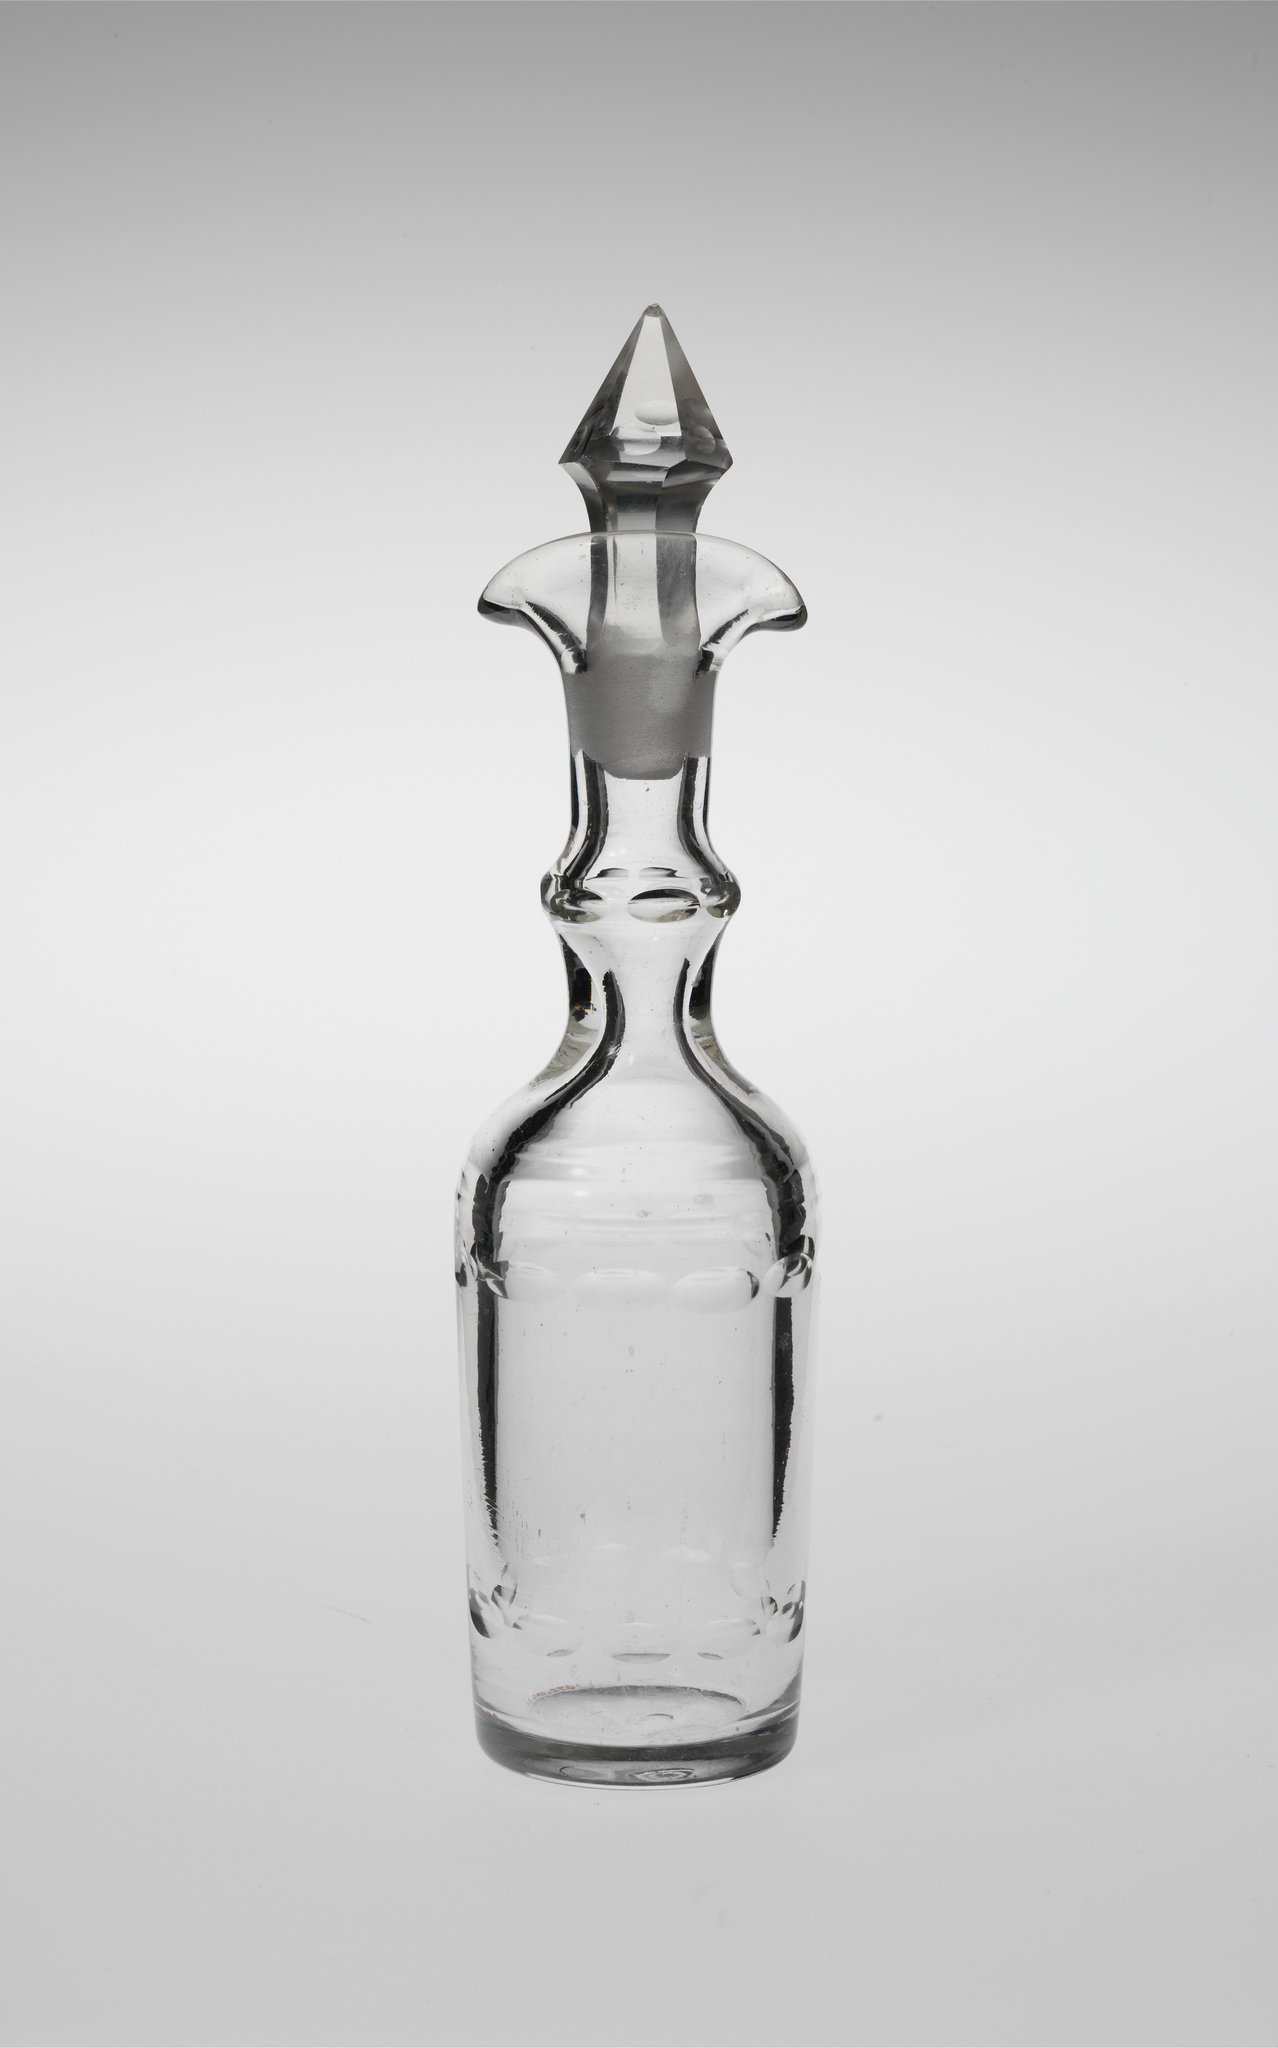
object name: bottle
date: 1700-1800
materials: glass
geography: ireland